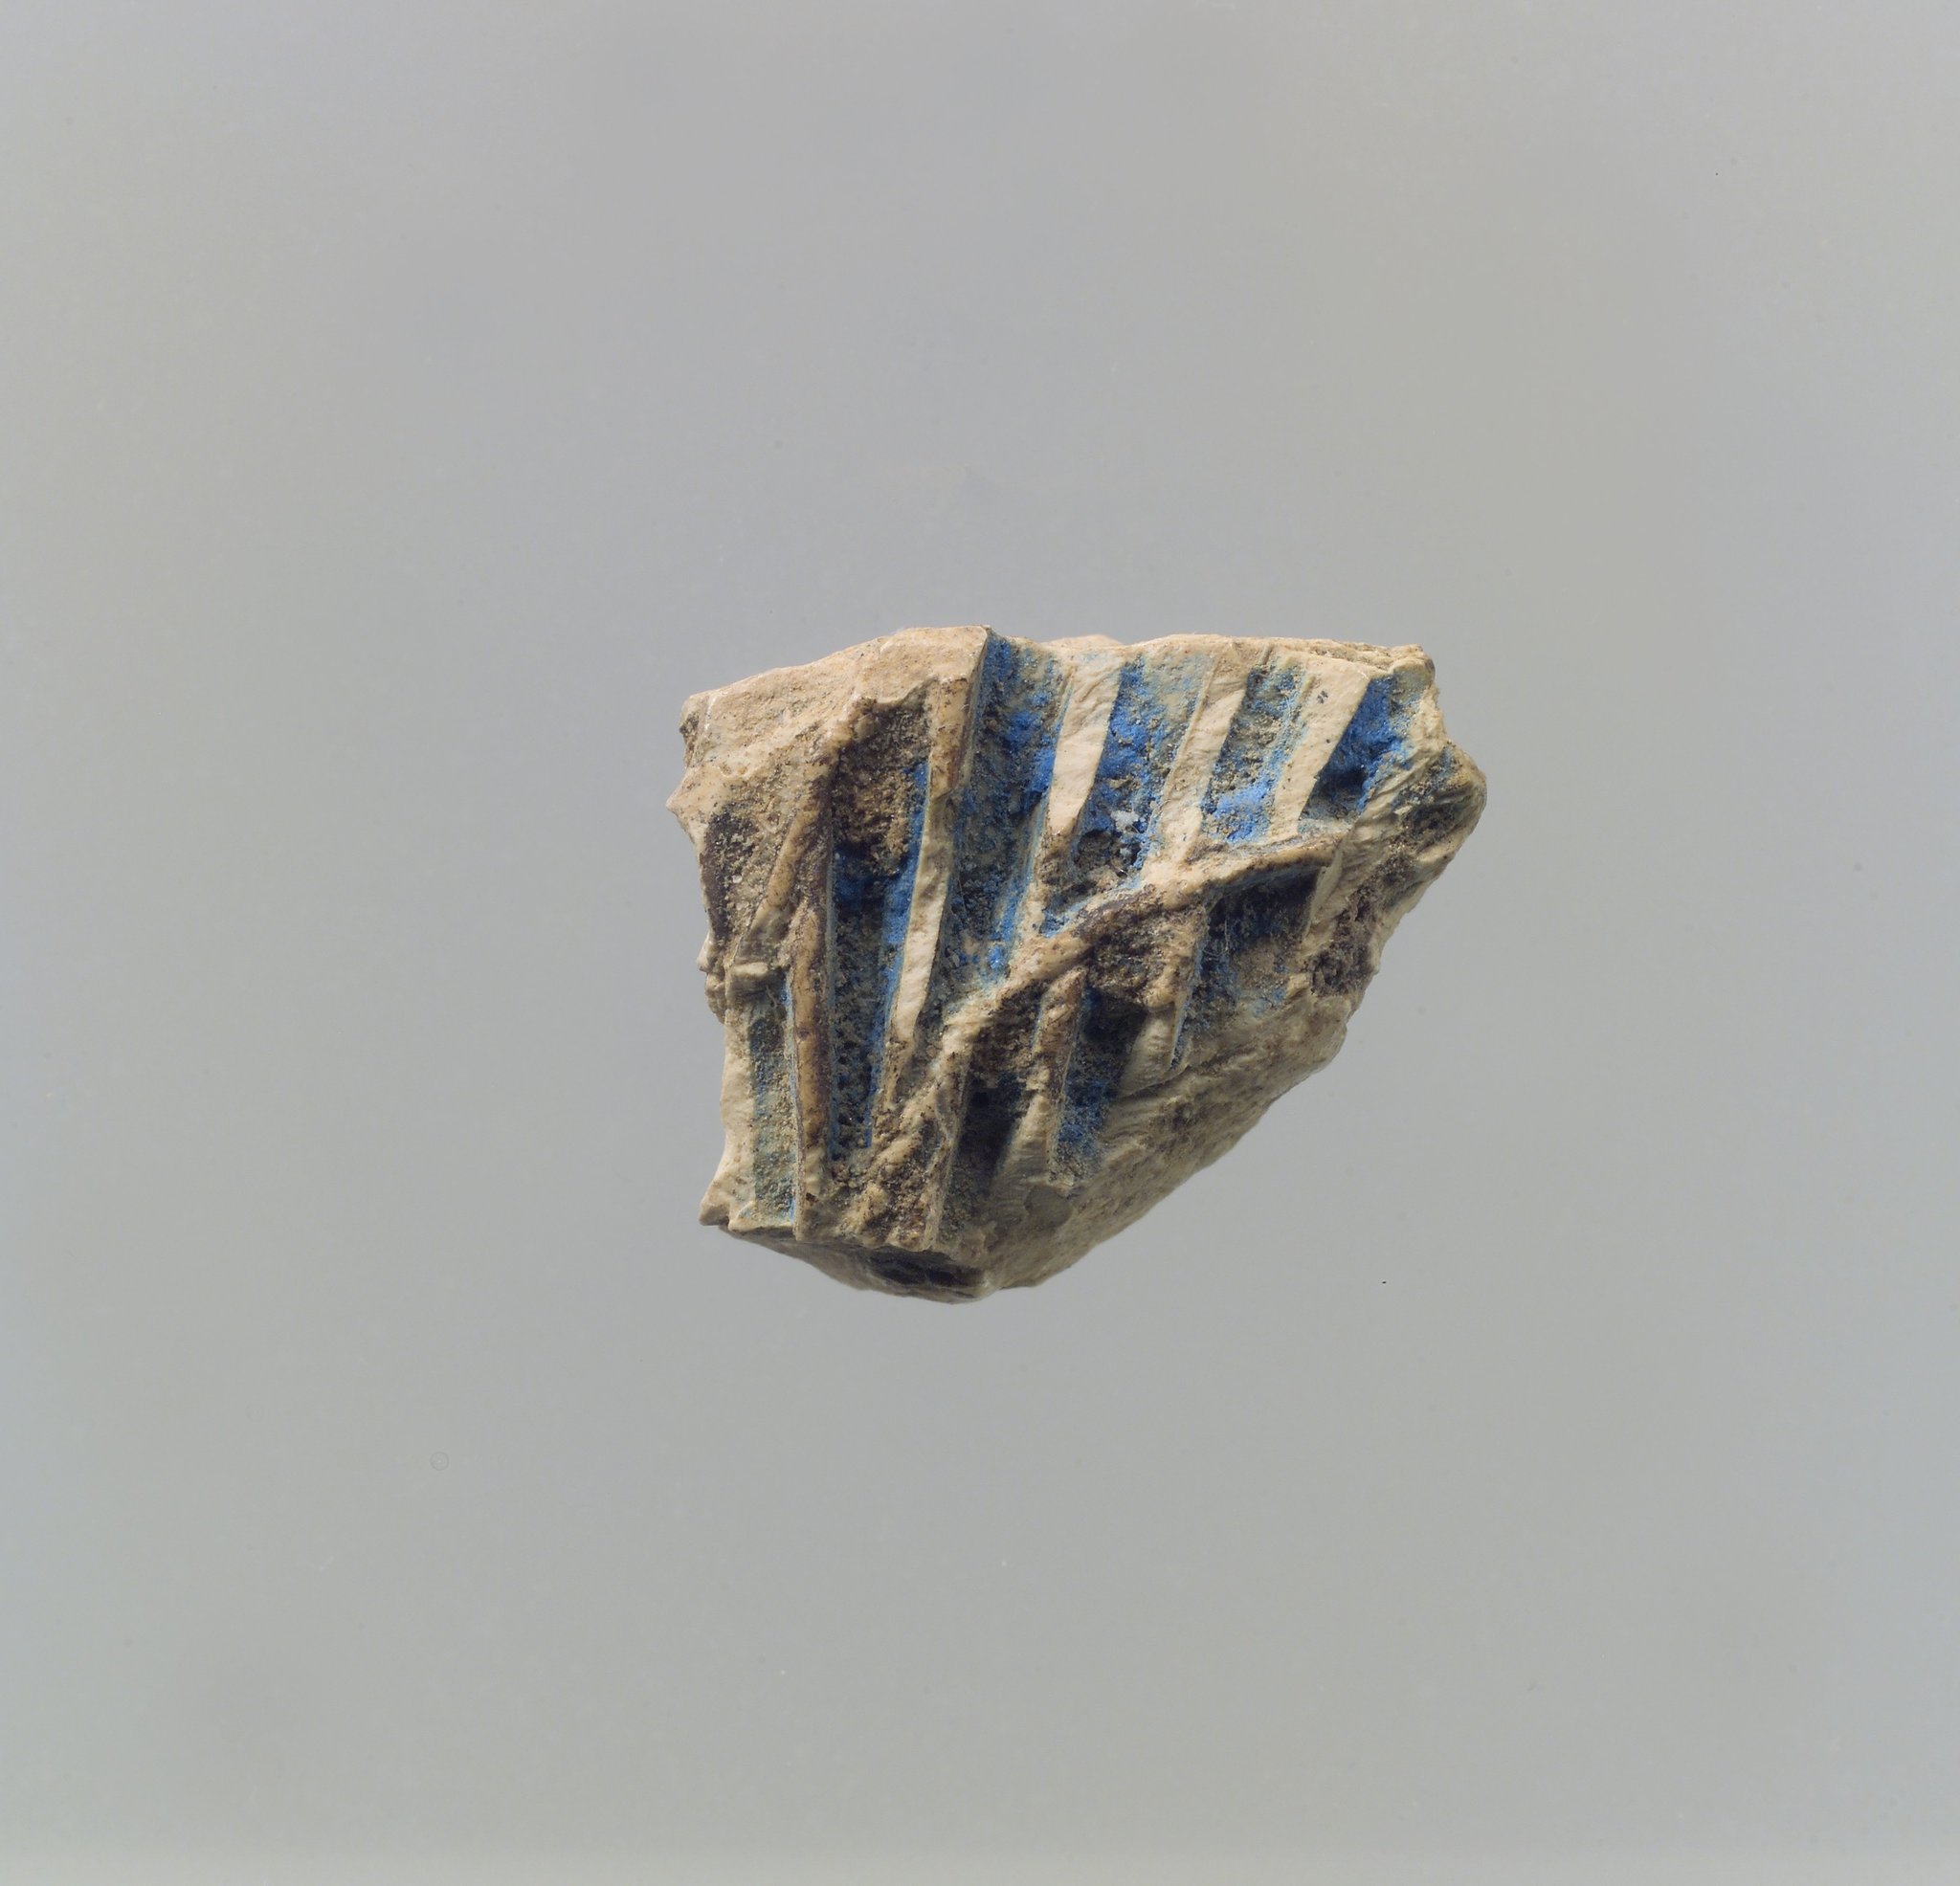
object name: relief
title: Plaque fragment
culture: assyrian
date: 800-601 BCE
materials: ivory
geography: mesopotamia